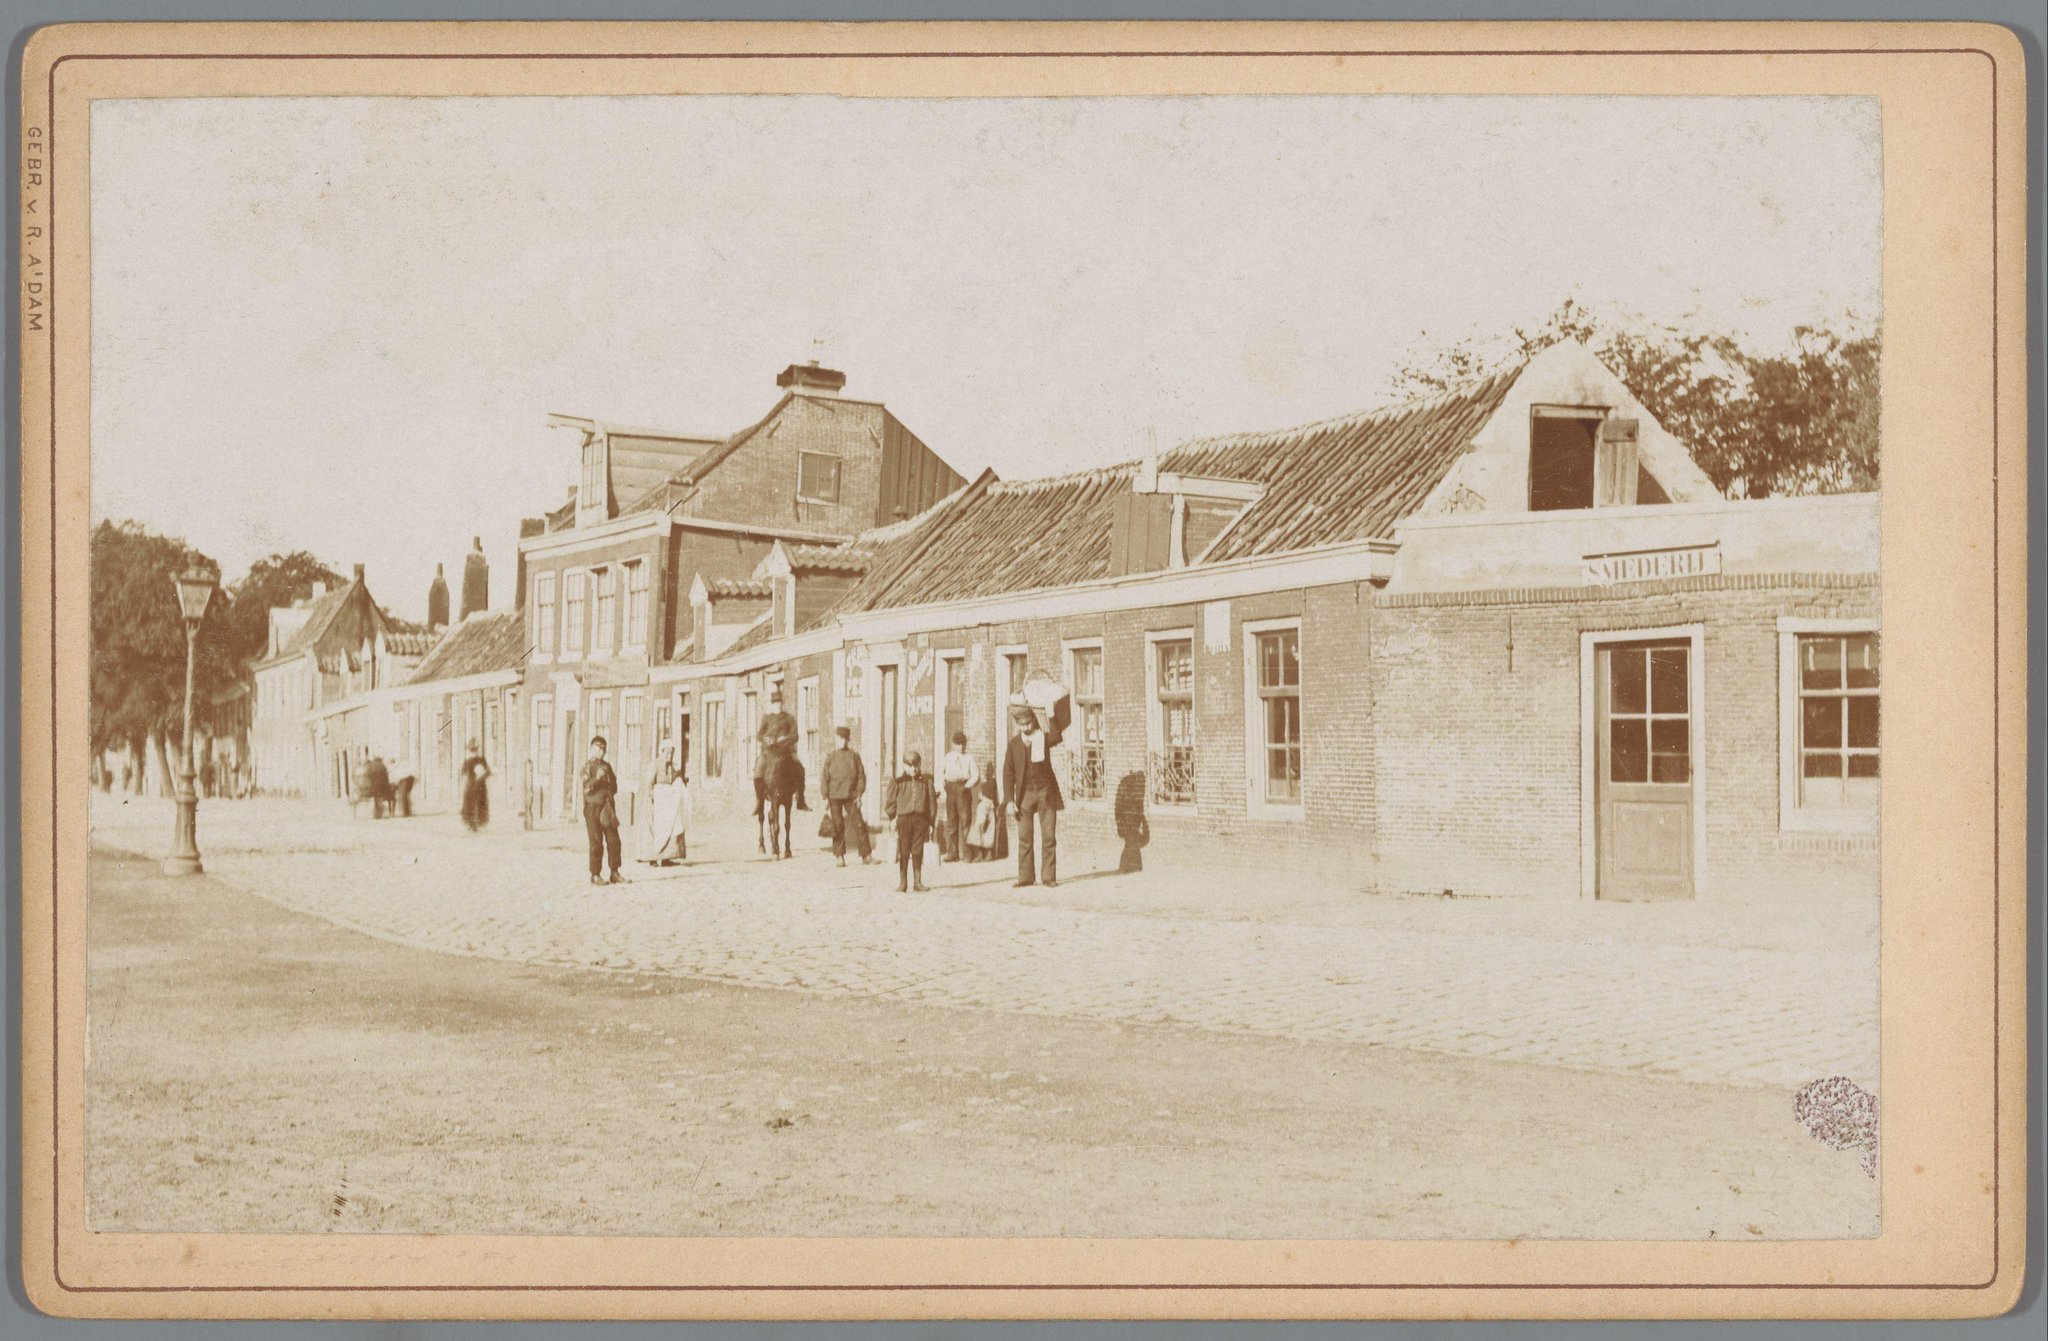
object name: cabinet photograph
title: Gezicht op huizen aan de Buitensingel buiten de Raambarrière in Amsterdam, nu bekend als de Nassaukade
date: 1880-1900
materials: cardboard, photographic support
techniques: collodion silver print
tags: the usual house or row of houses, street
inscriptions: name: ‘Vosmaer’, inscription: ‘Oude Huizen aan de voormalige Buitensingel buiten de Raambarière allen afgebroken. thans de Nassaukade bij de Hugo de Grootkade.’